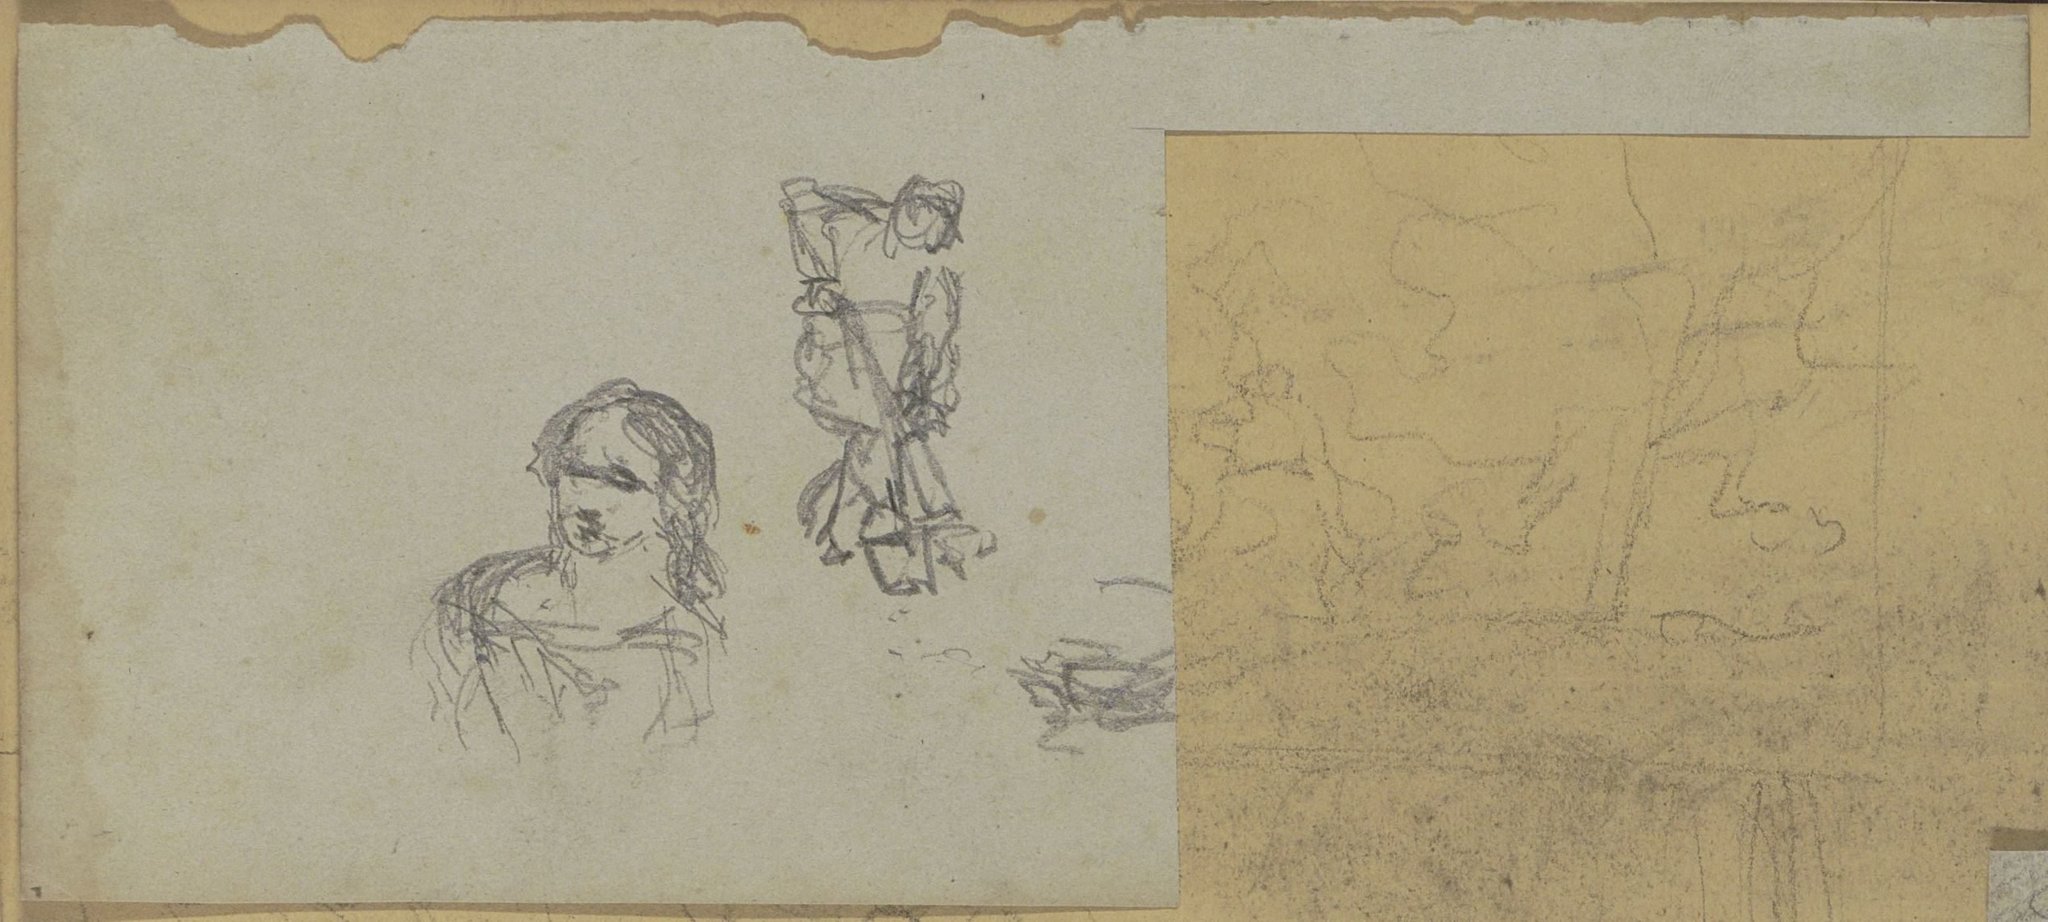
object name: sketchbook leaf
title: Vrouw en een figuur met een werktuig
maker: willem roelofs (i)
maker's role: draughtsman, painter, print maker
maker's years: 1822-1897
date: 1846-1851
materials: paper, pencil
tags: tools, aids, implements ~ crafts and industries, head (human)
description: Recto van een losse tekening tussen blad 19 en 20 uit een schetsboek met 25 bladen.